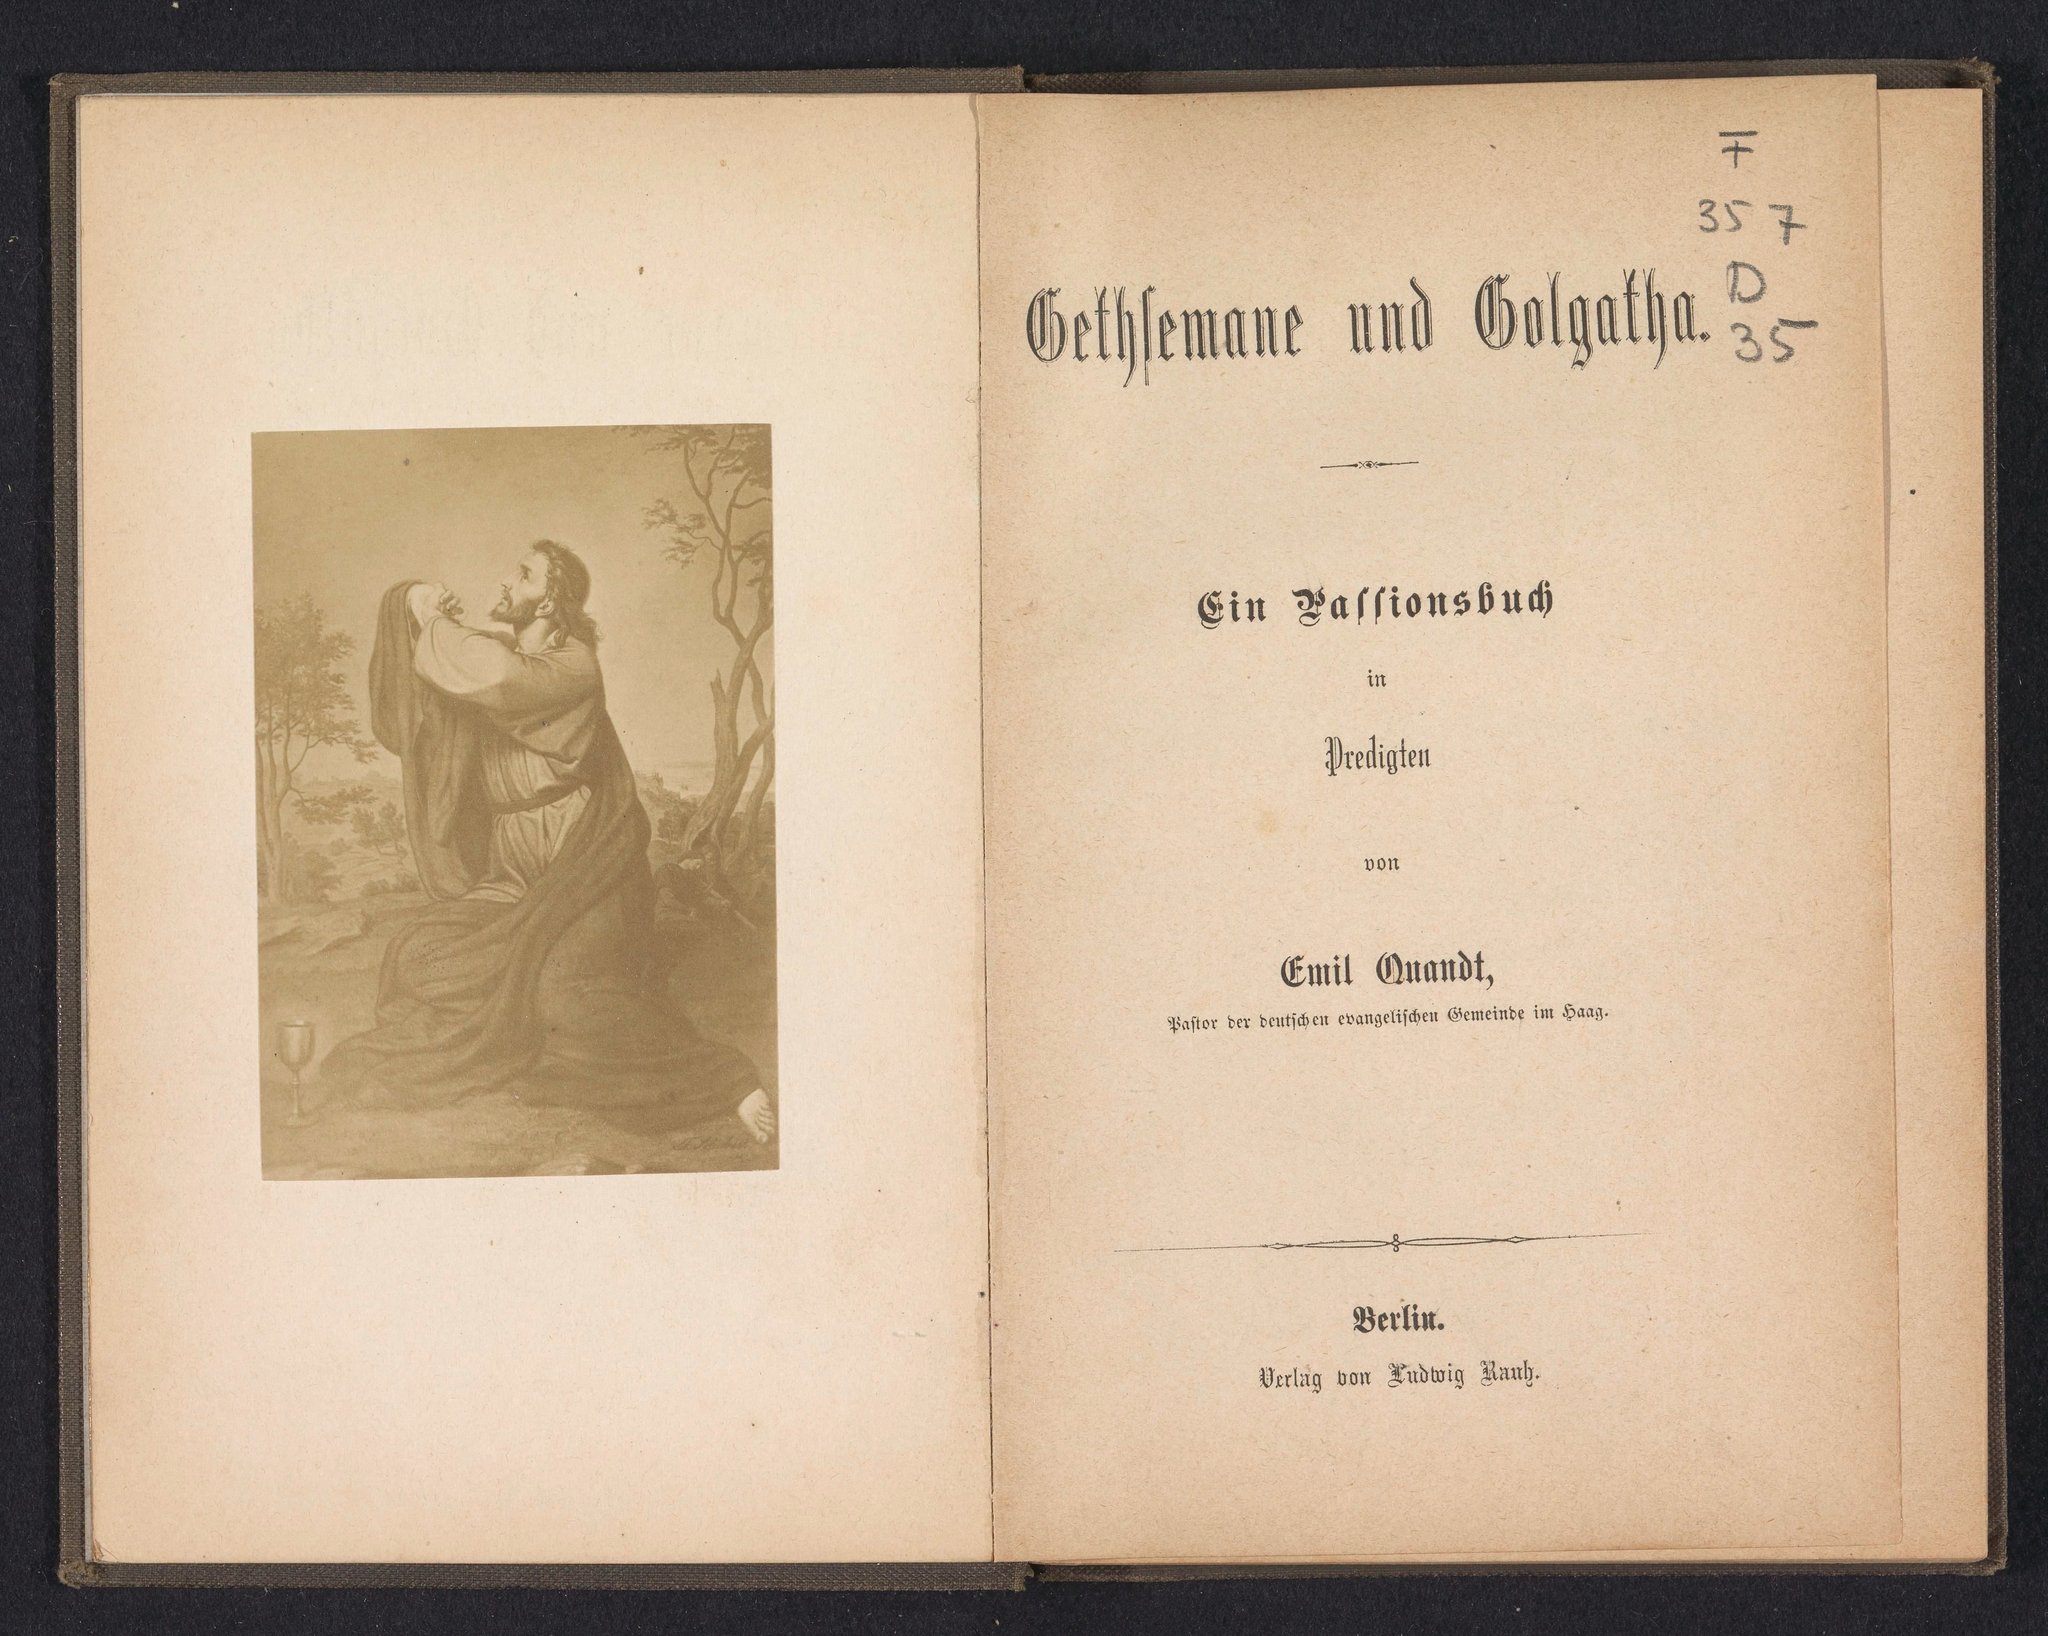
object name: photograph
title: Fotoreproductie van een schilderij, voorstellende Christus in de Hof van Getsemane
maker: Anonymous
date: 1868-1873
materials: photographic support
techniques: albumen print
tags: christ's prayer in the garden of gethsemane during the night